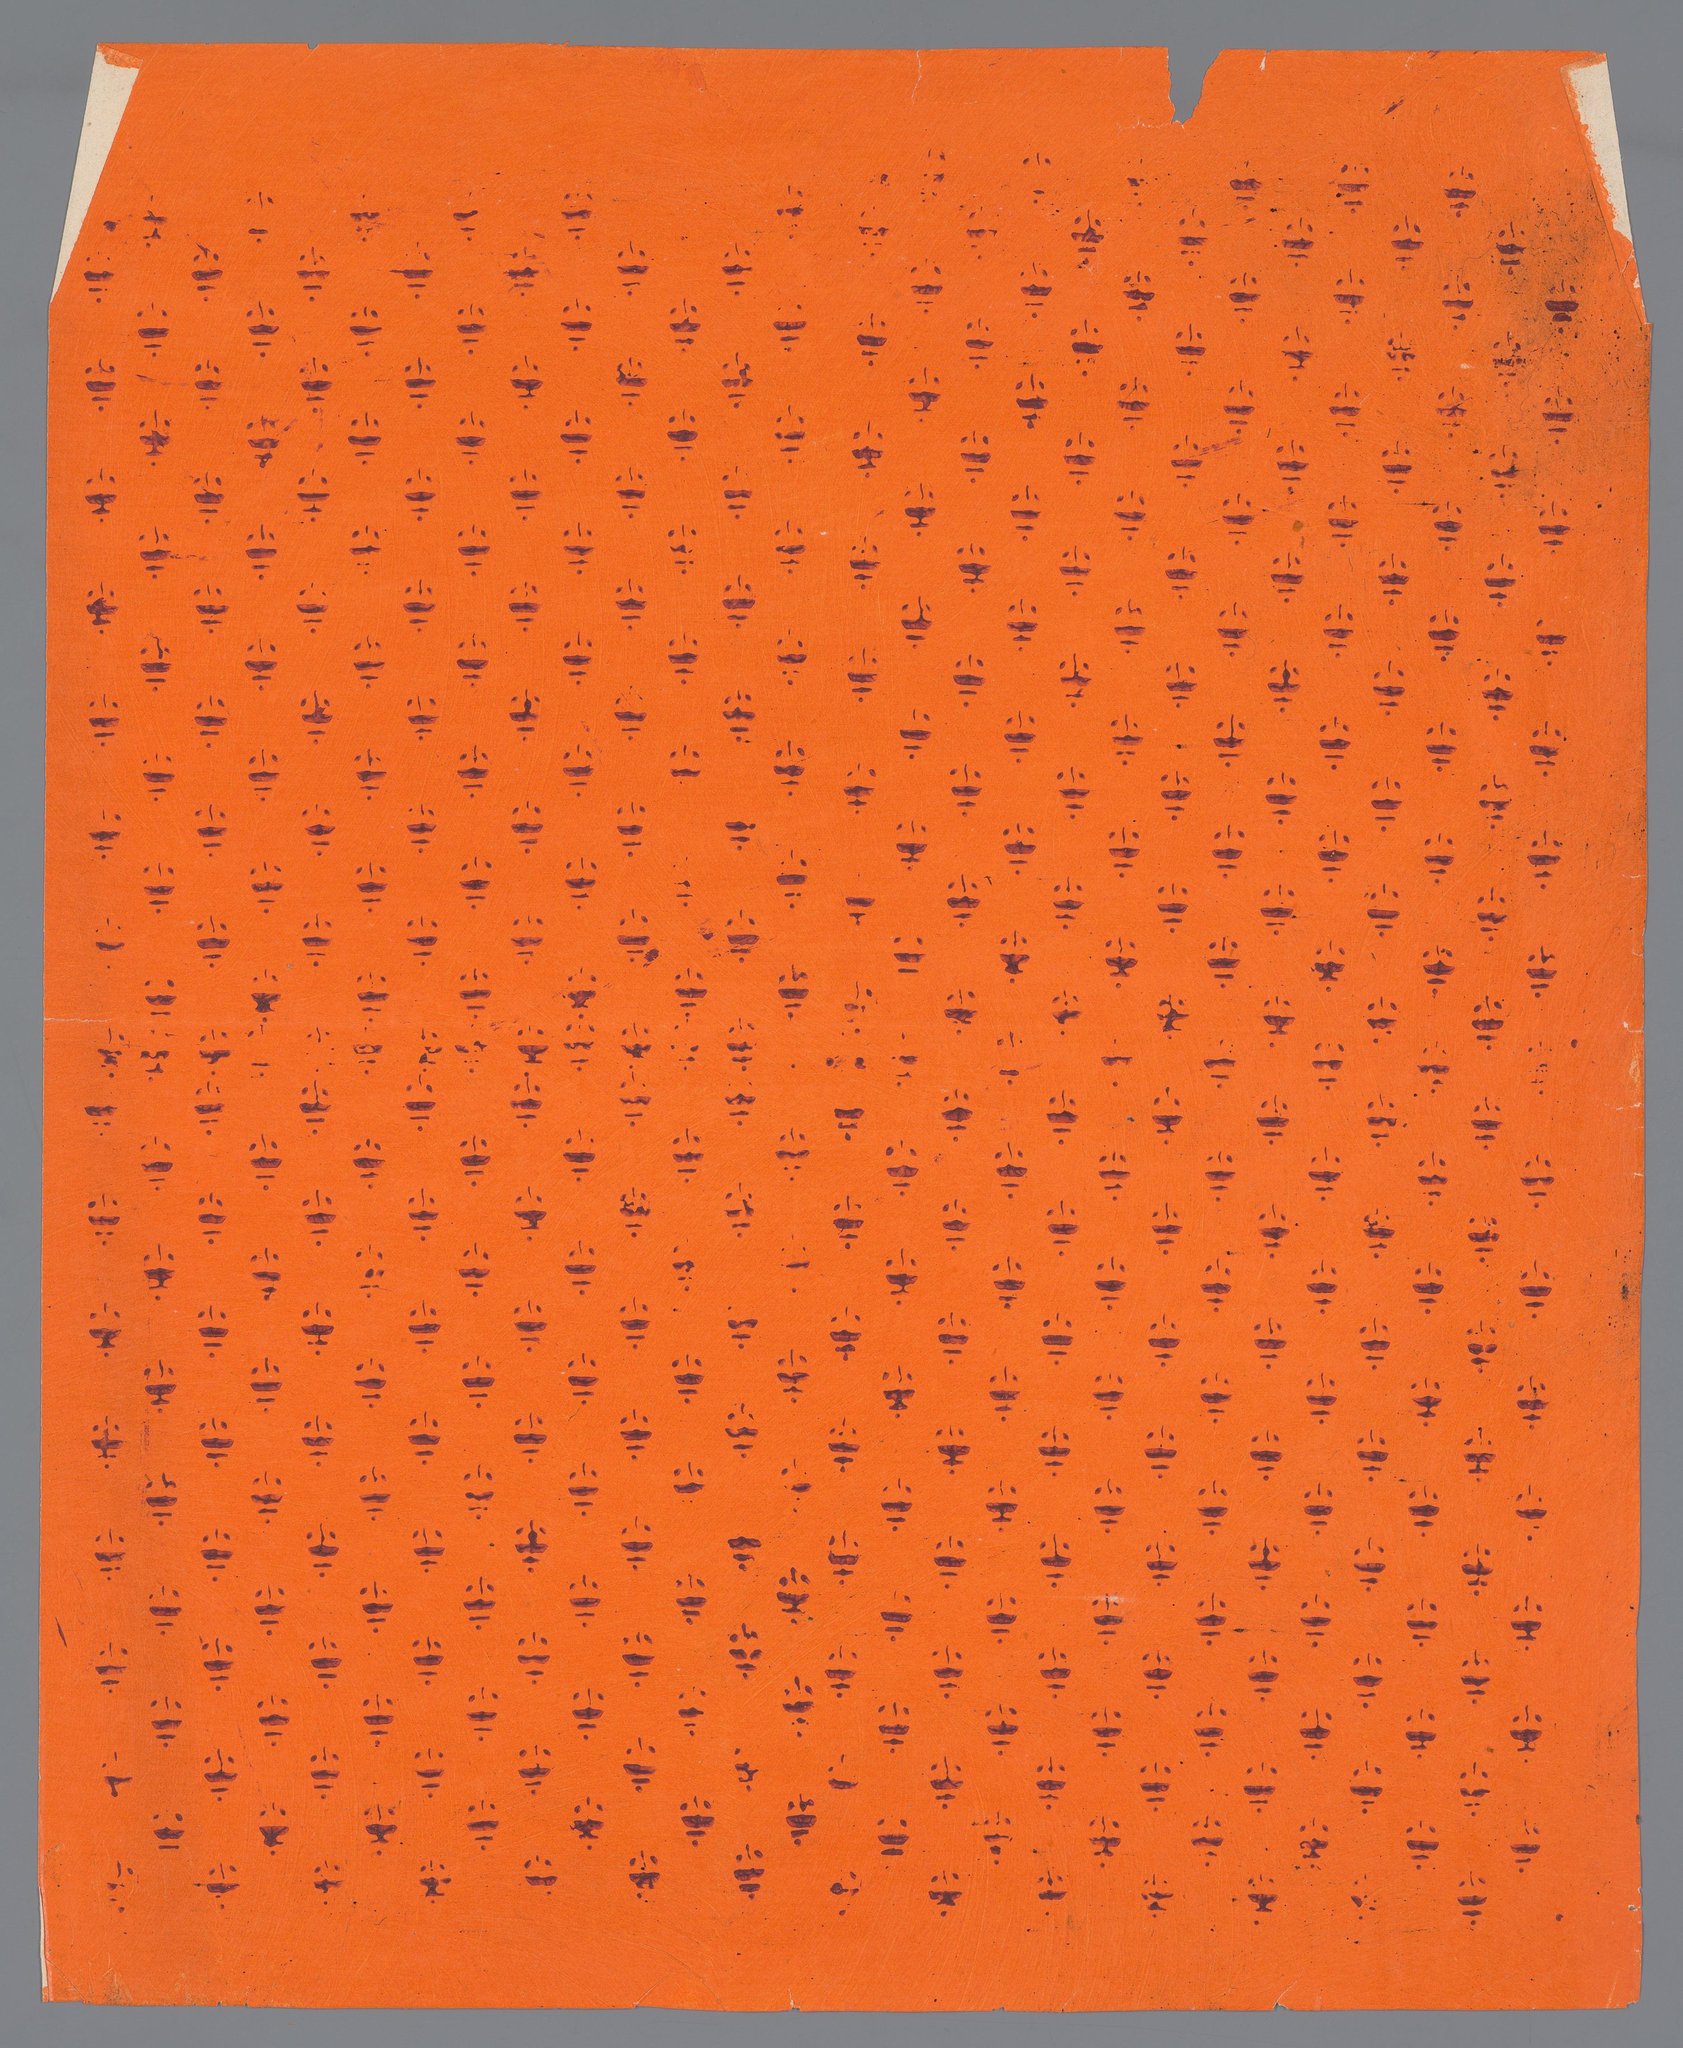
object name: printed paper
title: Blad met patroon van gestileerd floraal motief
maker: Anonymous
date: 1850-1950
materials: lacquer, paint, paper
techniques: printing block, lacquer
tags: ornament derived from plant forms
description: Blad met regelmatig fantasiepatroon met een gestileerd knol- of potvormig floraal motief.